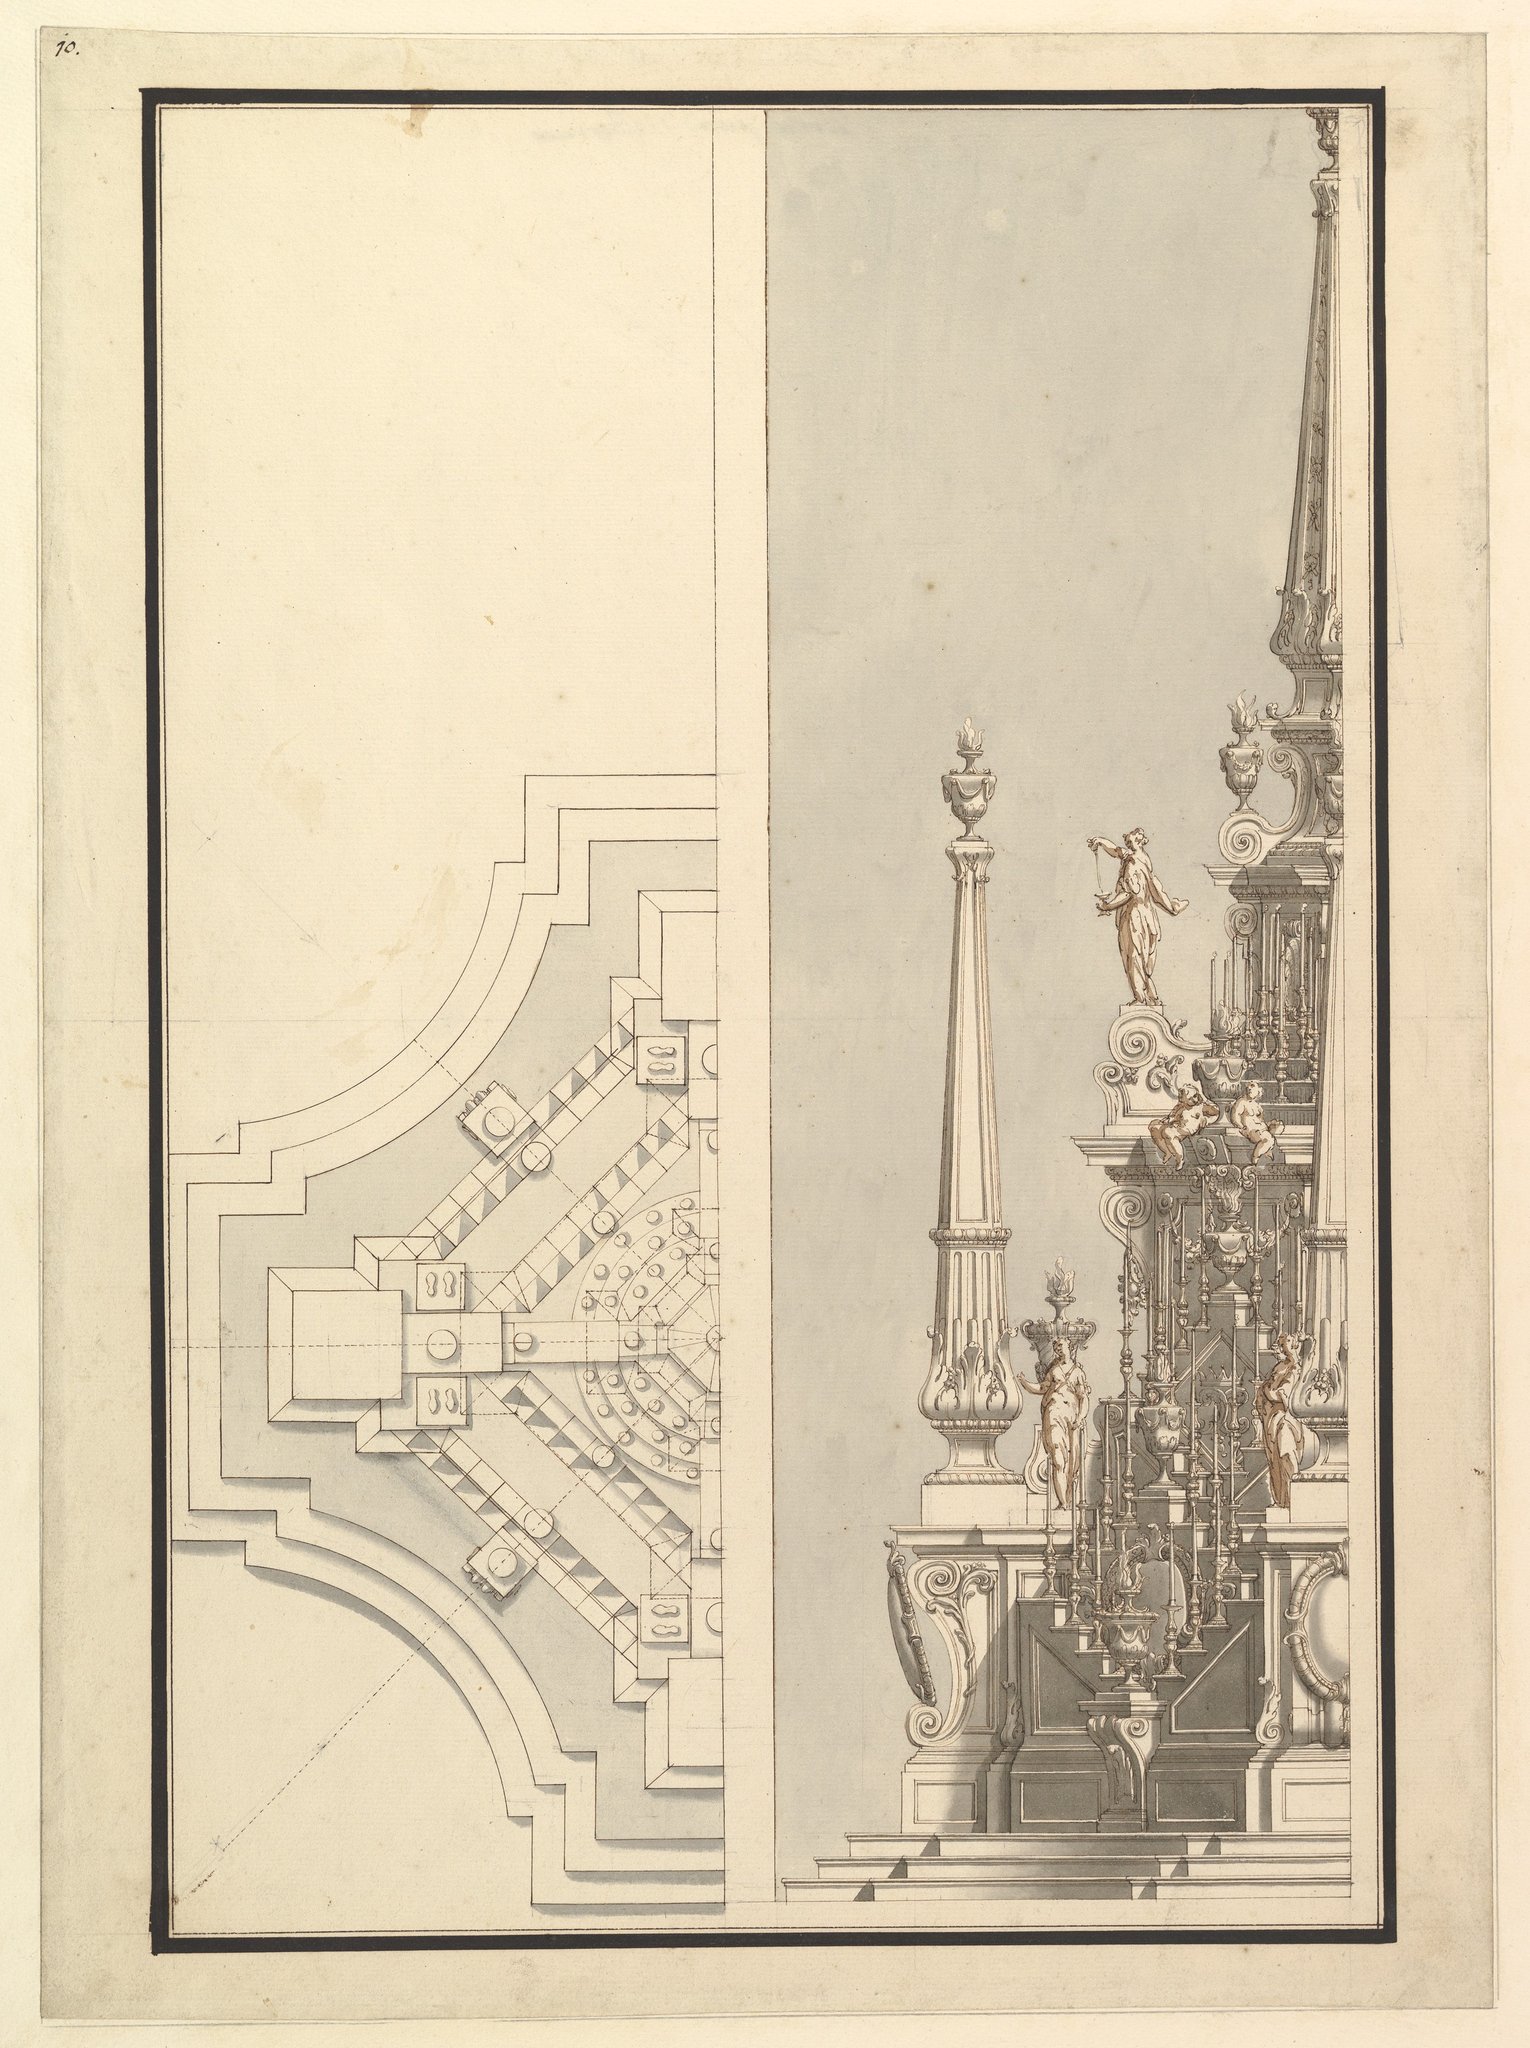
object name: drawing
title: Half Ground Plan, Half elevation for a Catafalque for a Duchess de Berri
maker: giuseppe galli bibiena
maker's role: artist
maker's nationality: italian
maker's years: 1696-1756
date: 1696-1756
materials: ink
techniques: pen, wash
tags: architecture